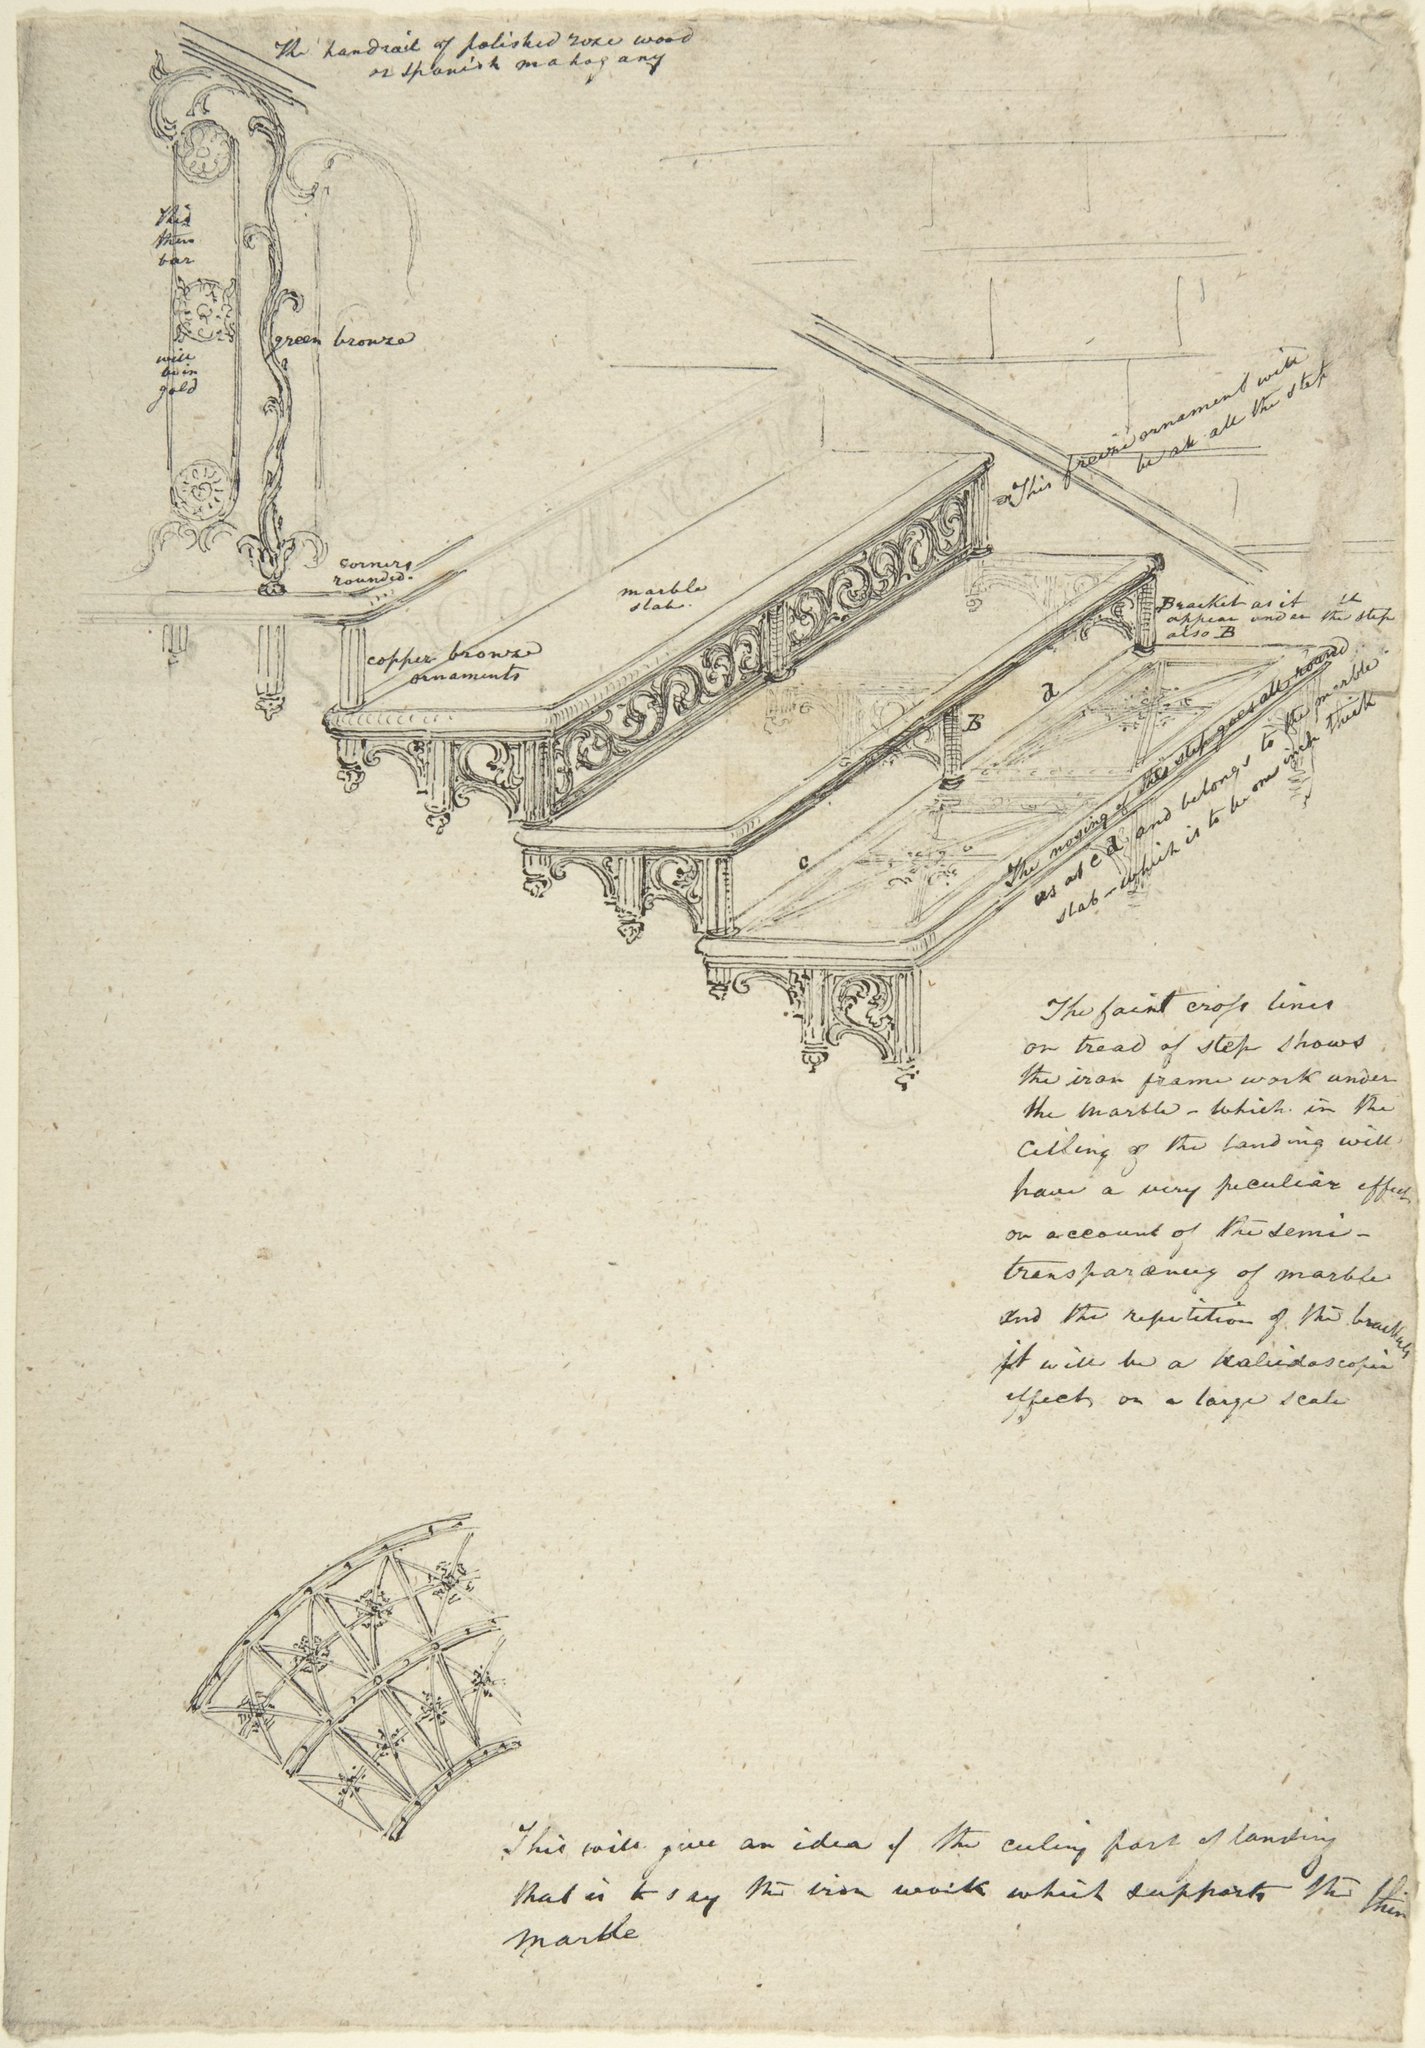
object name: drawing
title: Drawing for an iron stairway with marble treads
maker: anonymous, british, 19th century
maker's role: artist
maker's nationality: british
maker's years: 1800-1900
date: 1801-1900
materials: graphite, ink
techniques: pen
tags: architecture,stairs